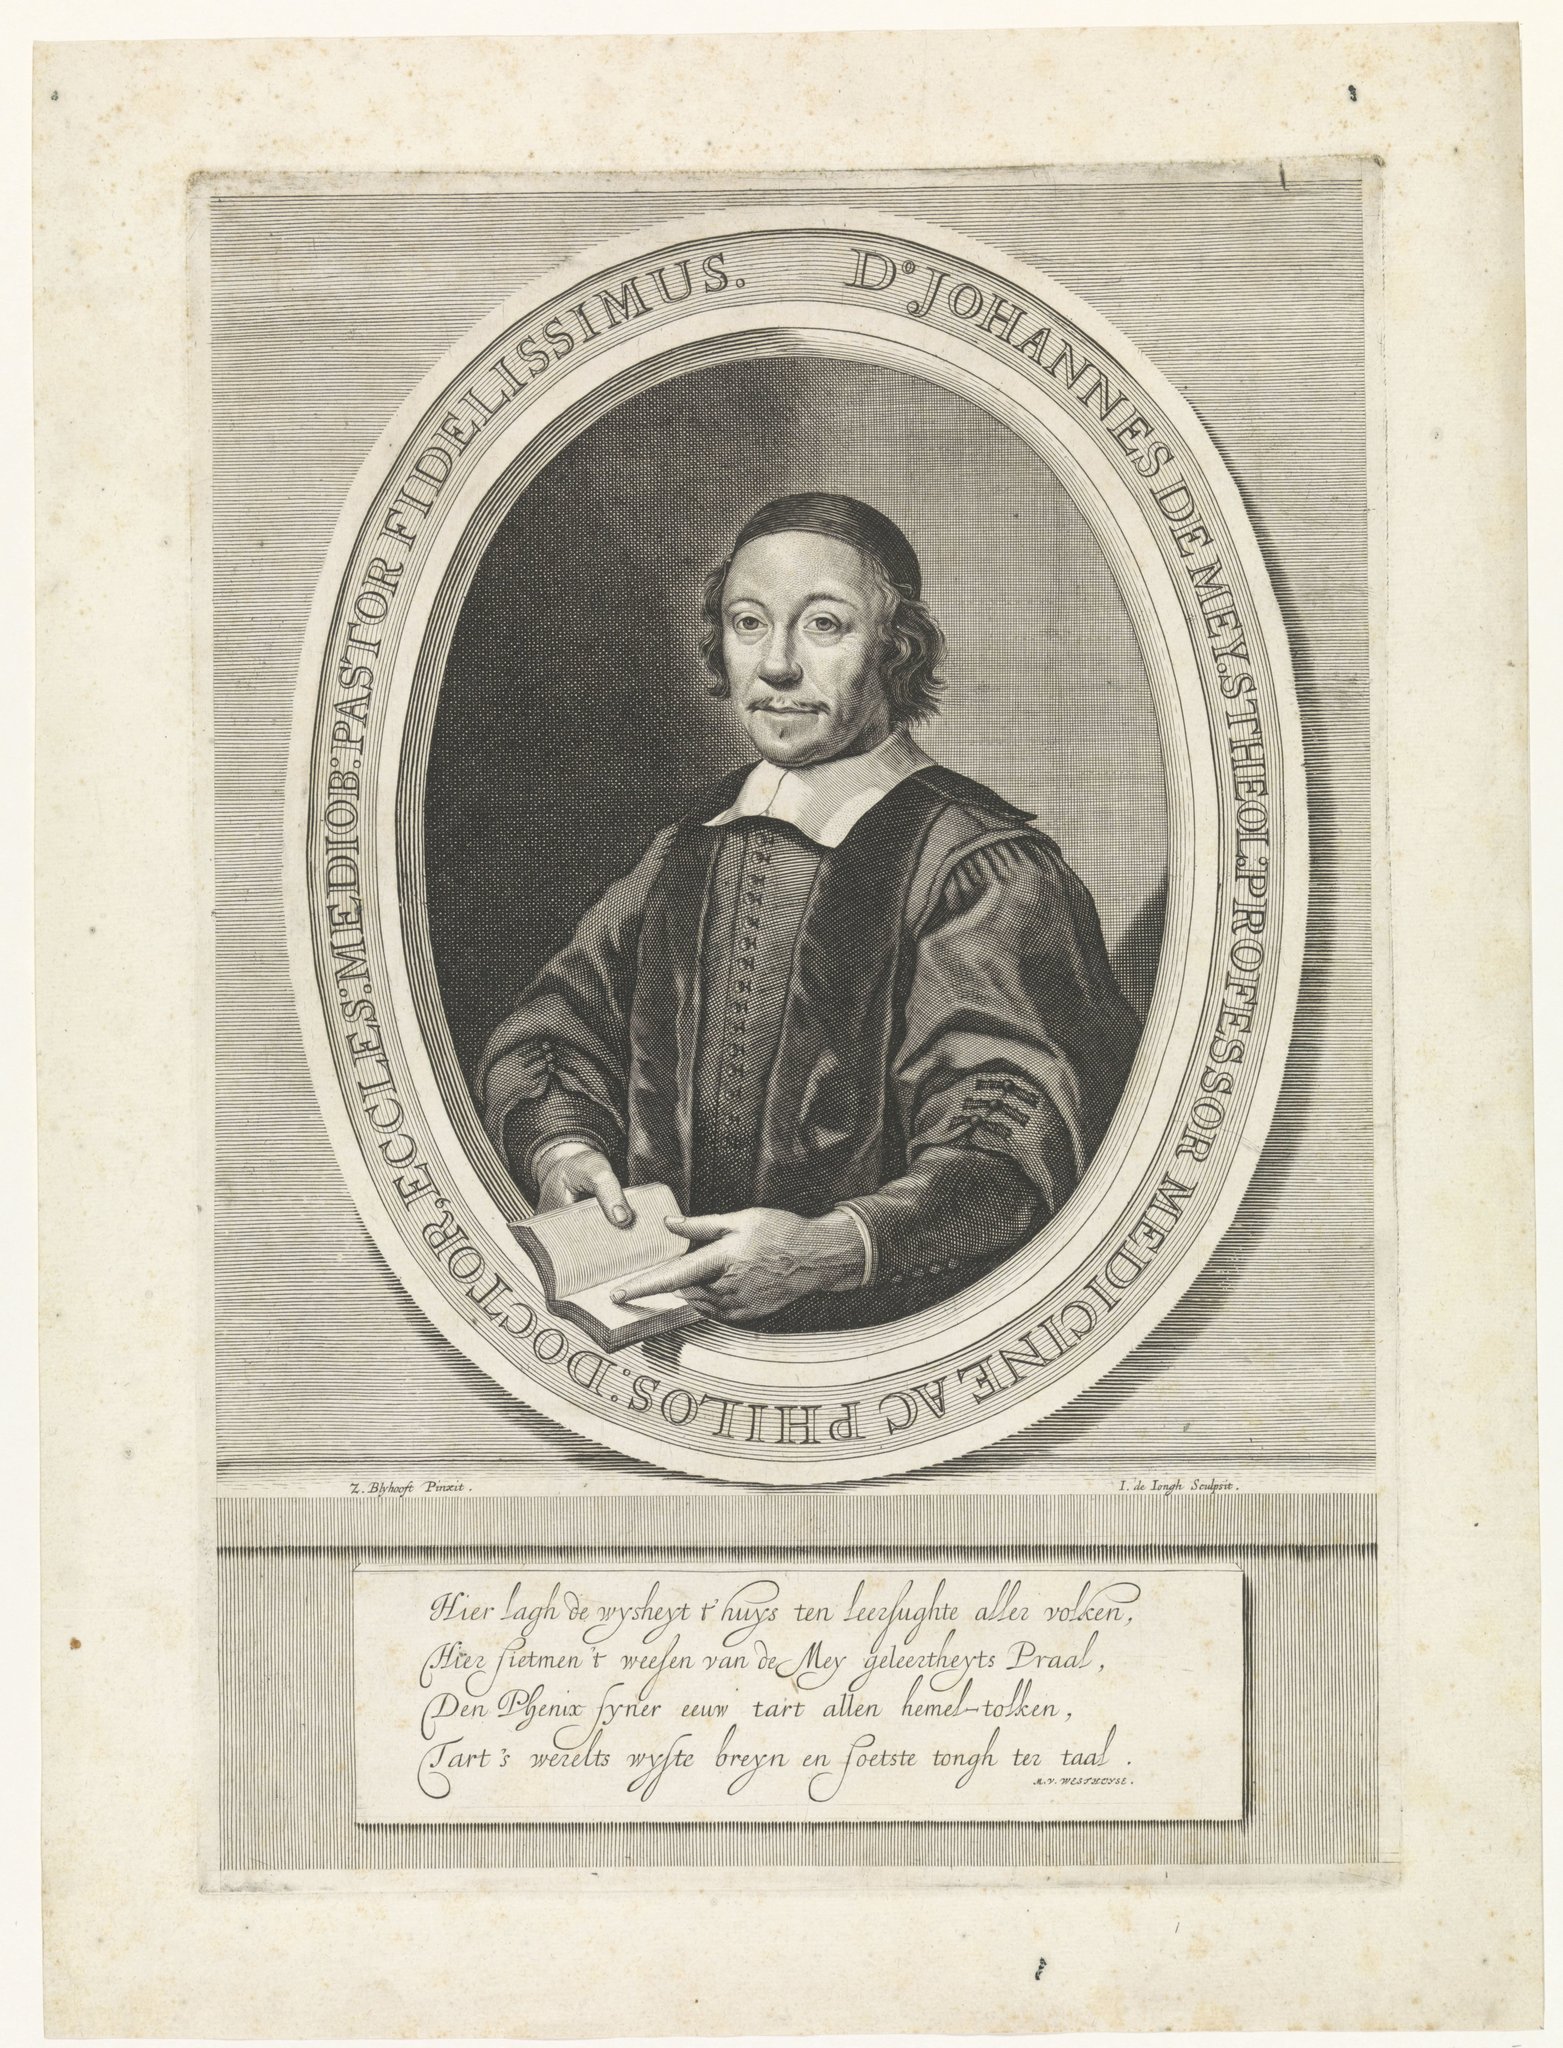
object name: print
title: Portret van Johannes de Mey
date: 1677-1679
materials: paper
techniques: engraving, etching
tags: middelburg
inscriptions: collector's mark: Lugt 2228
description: Busteportret van de theoloog Johannes de Mey, met kalot. In zijn rechterhand houdt hij een boek en met de wijsvinger van zijn linkerhand wijst hij naar een bladzijde. Het portret is gevat in een ovale omlijsting met een randschrift in het Latijn. In een kader een vierregelig gedicht in het Nederlands.